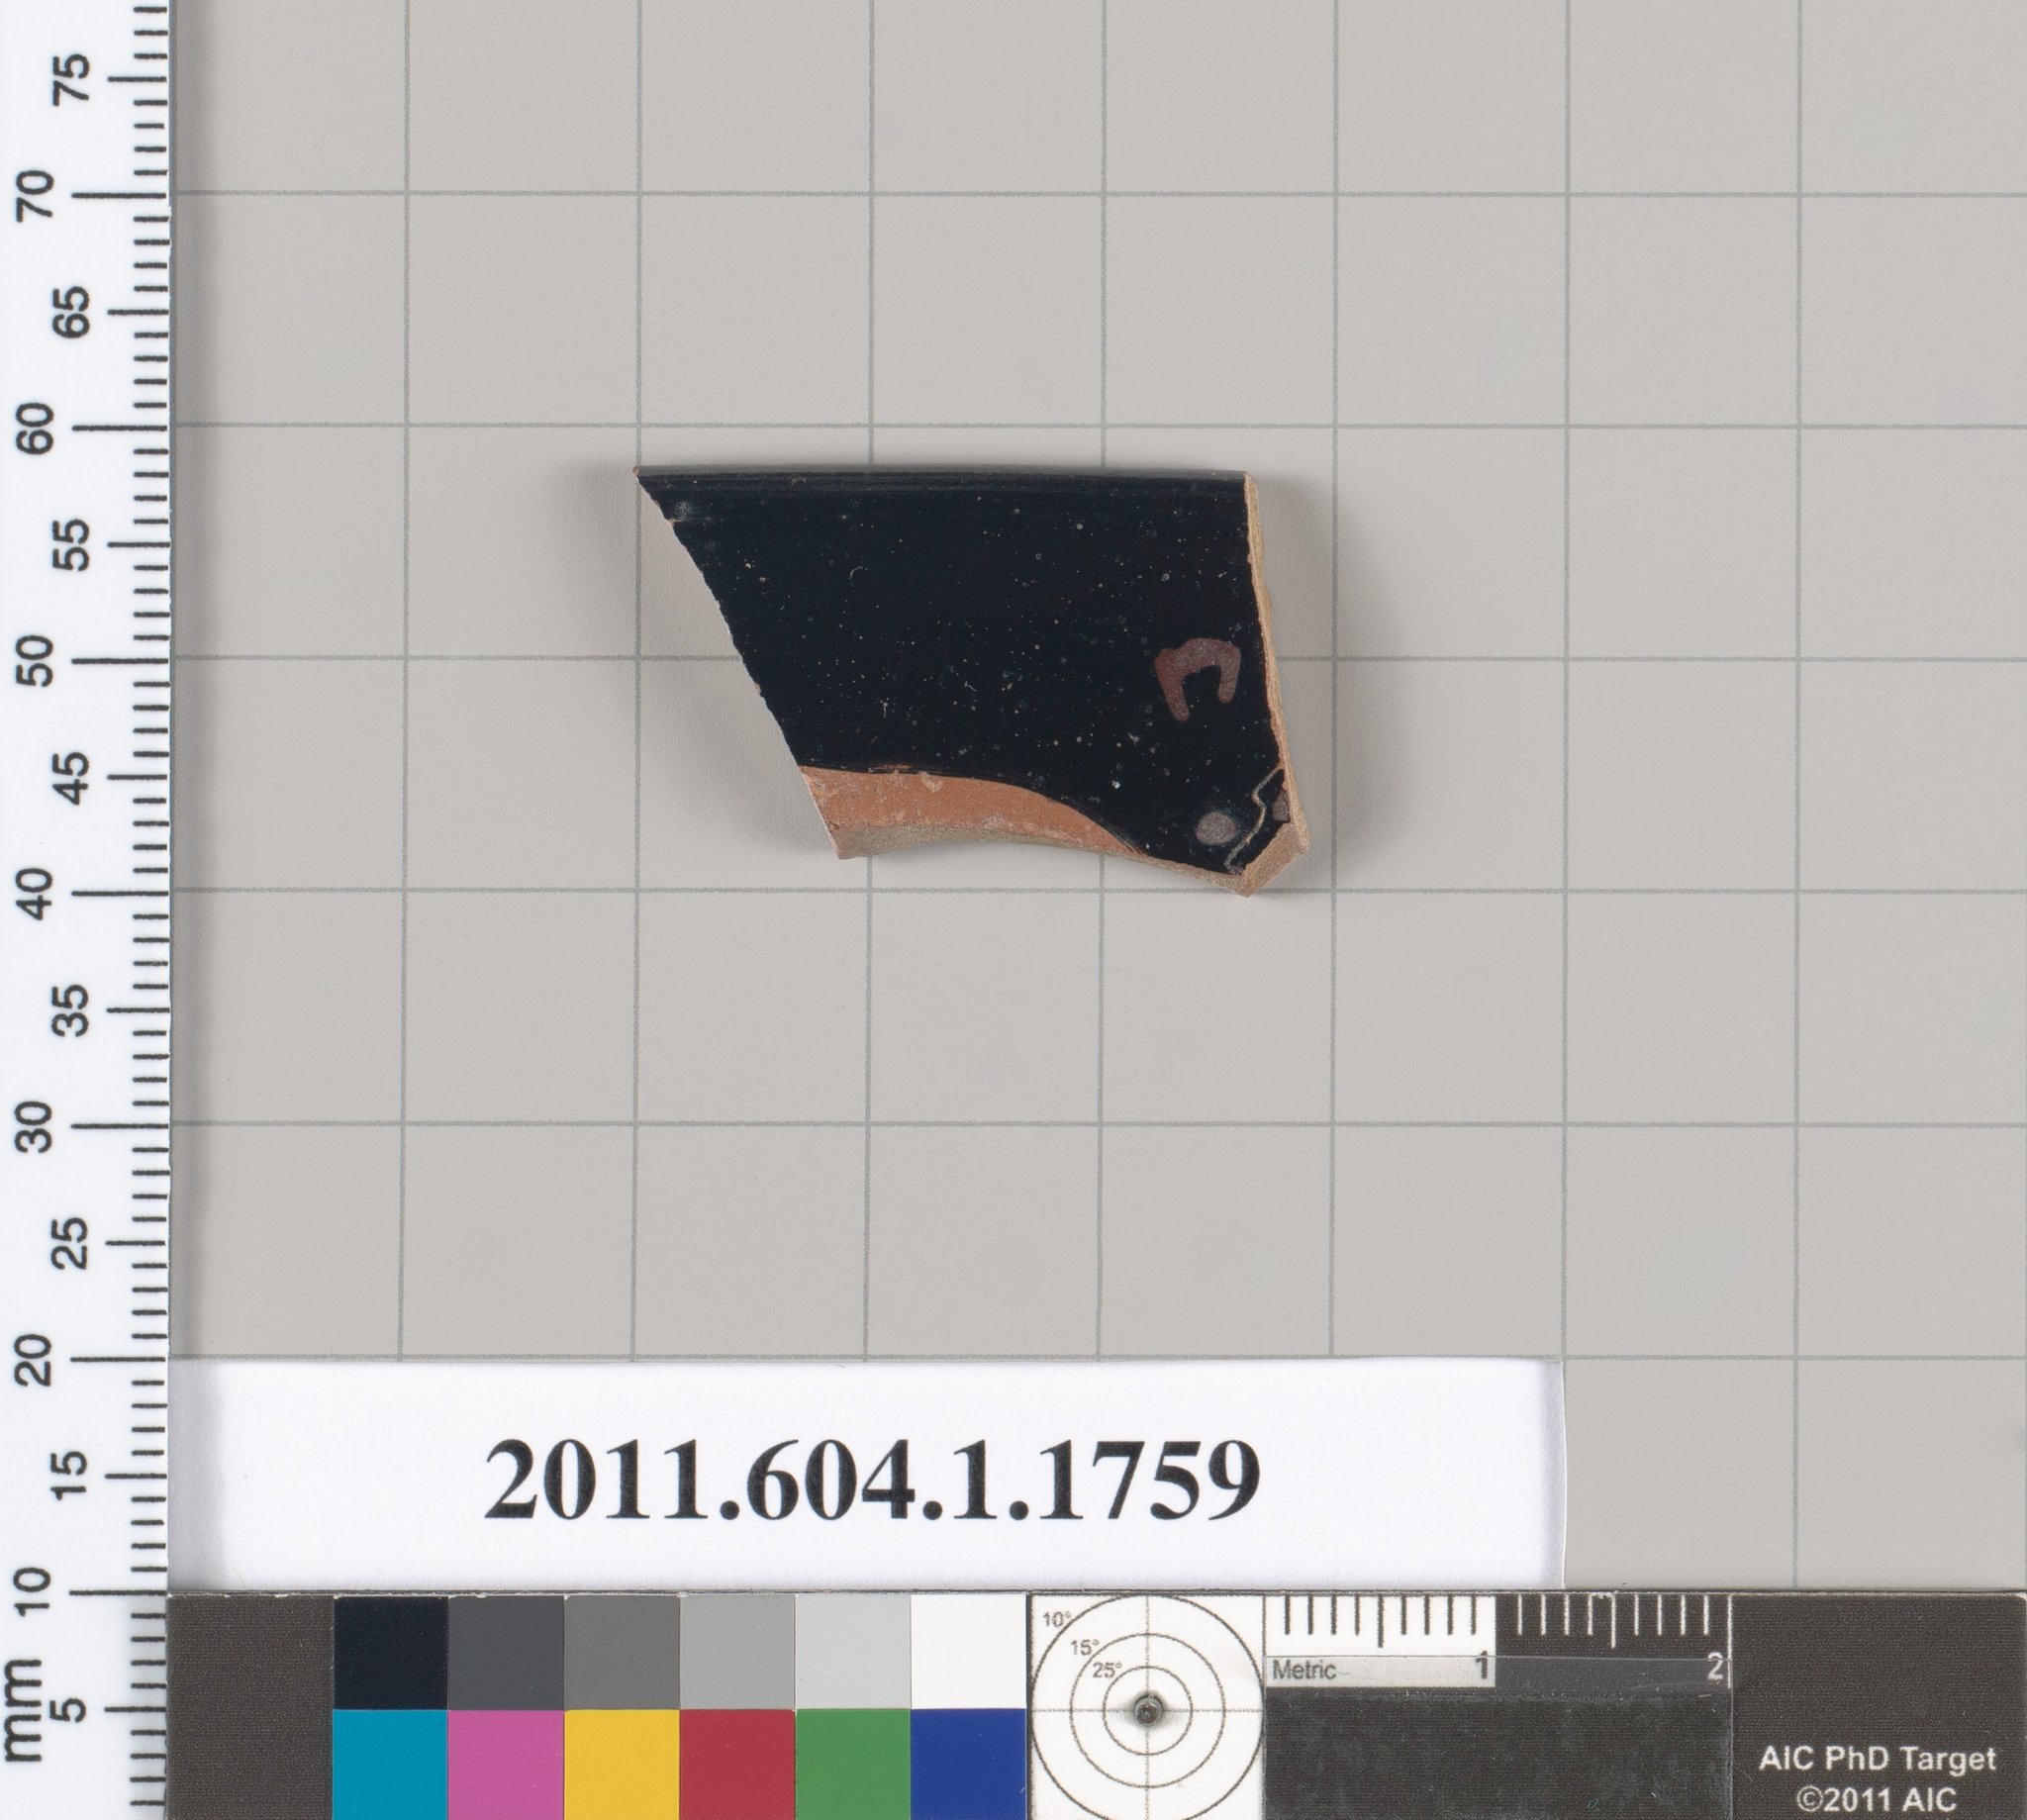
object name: kylix fragment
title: Terracotta rim fragment of a kylix (drinking cup)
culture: greek, attic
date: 475-451 BCE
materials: terracotta